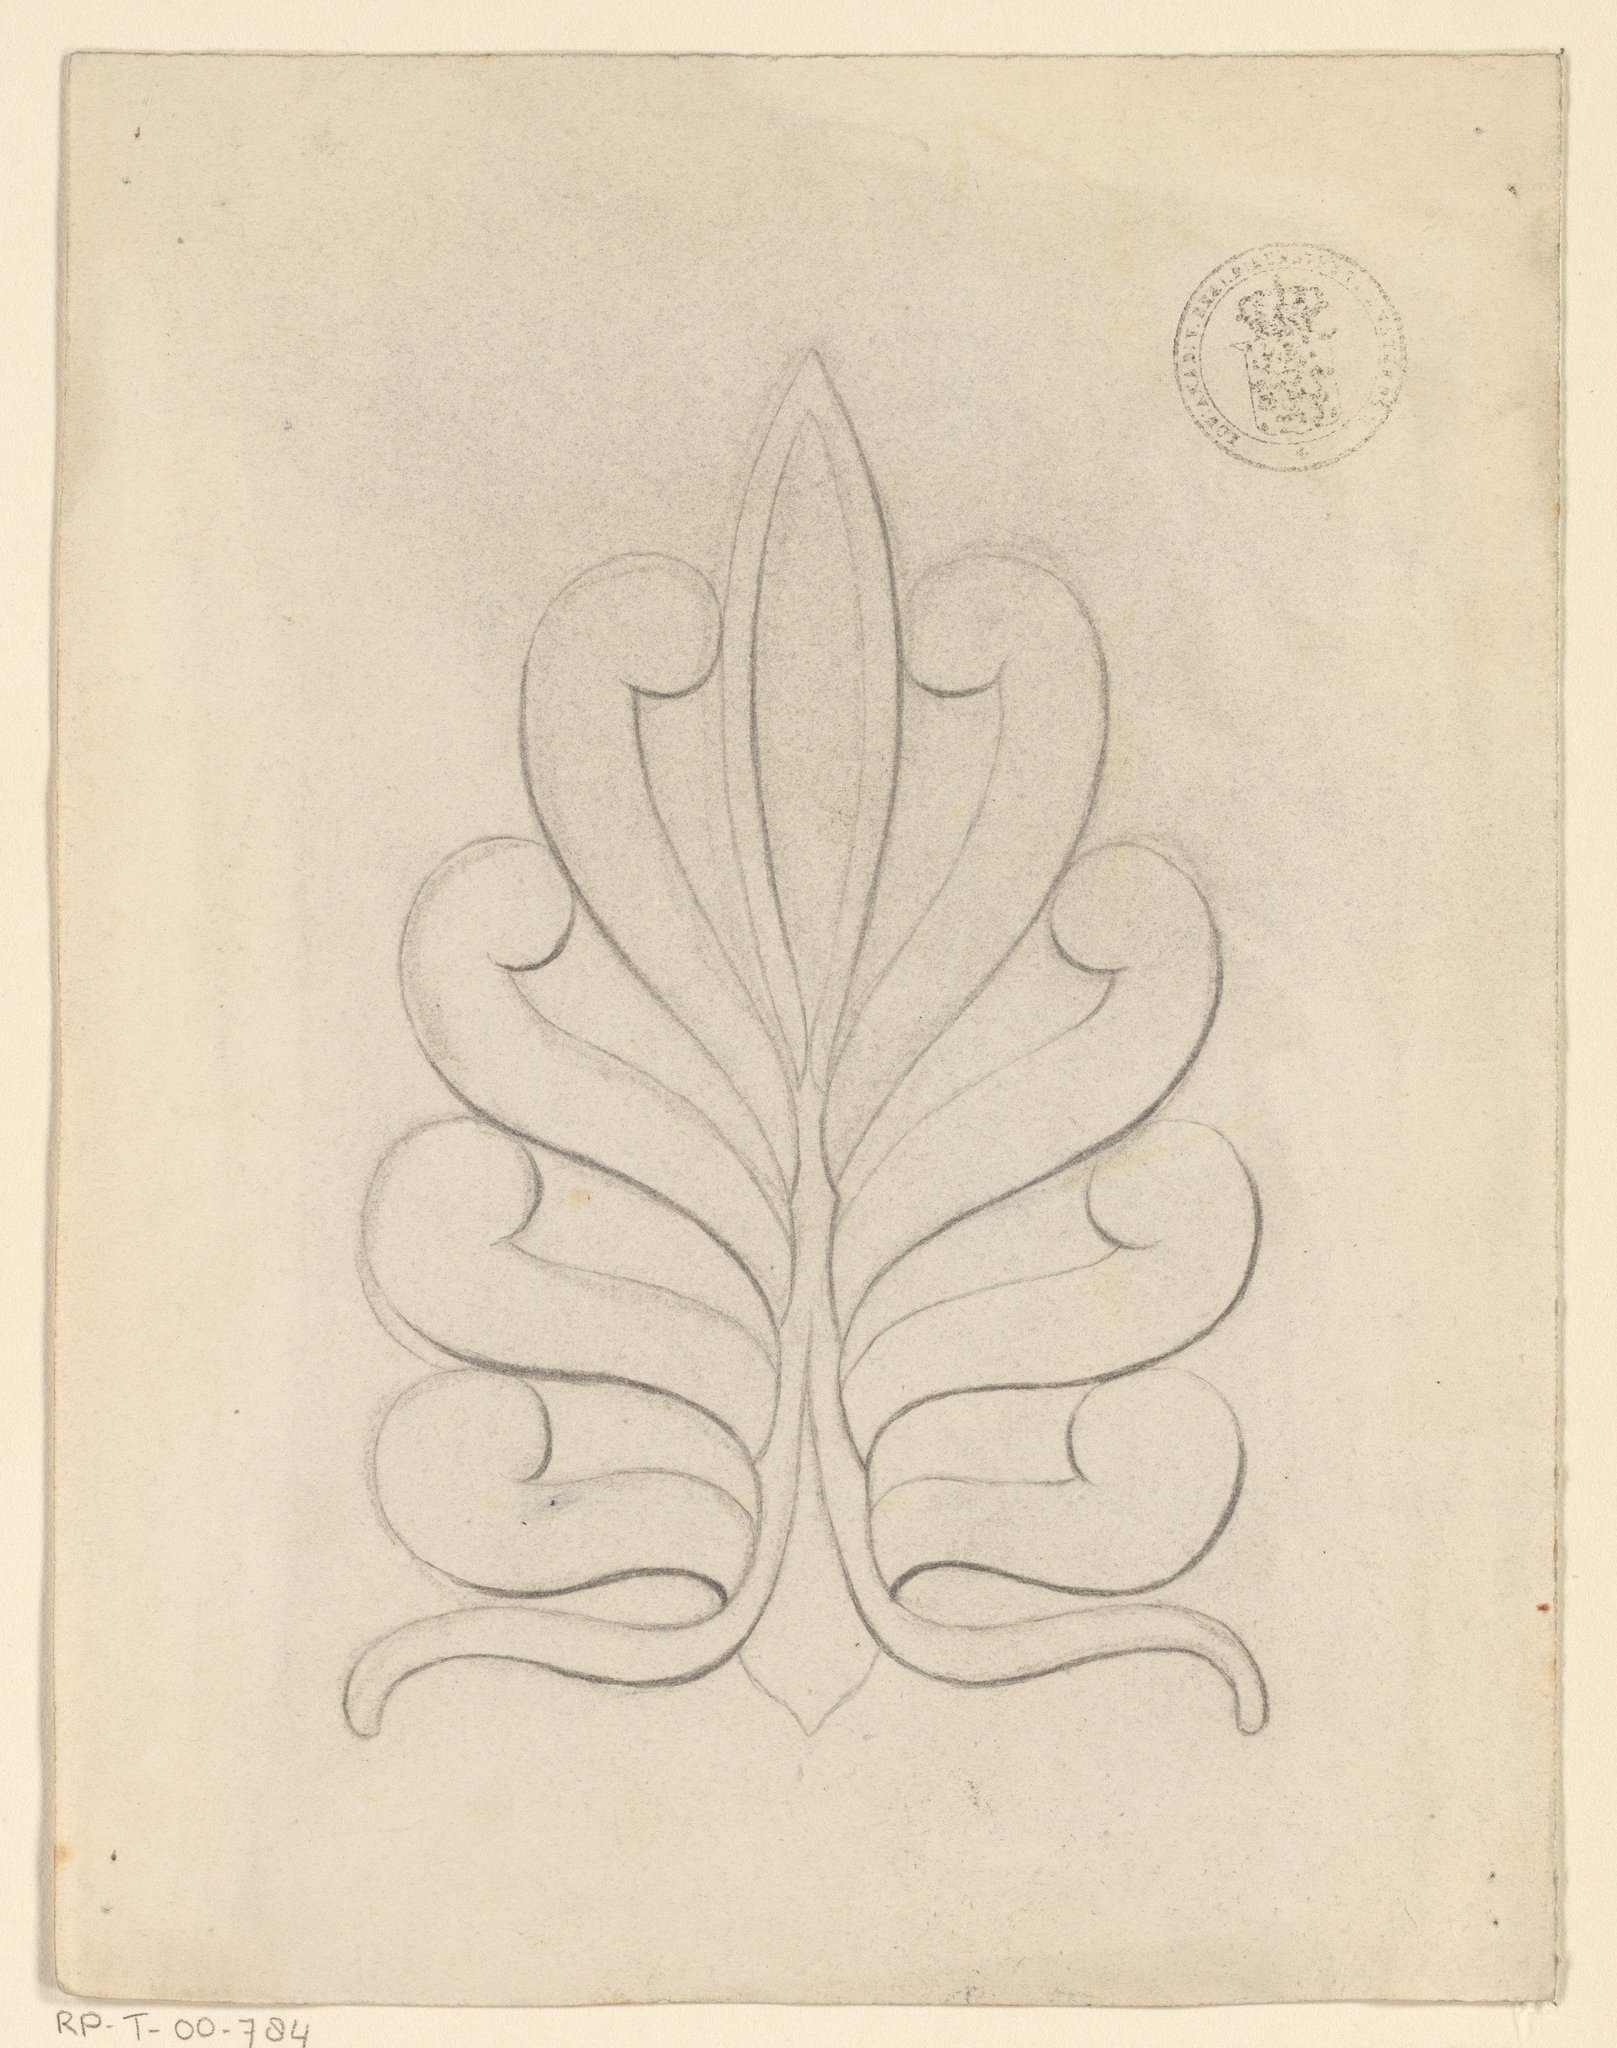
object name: ornamenttekening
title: Floraal ornament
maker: Anonymous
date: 1700-1900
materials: chalk, paper, pencil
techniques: pouncing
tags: flowers ~ ornament - aa - stylized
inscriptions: stamp: Lugt 10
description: Ontwerp voor een gestileerd floraal ornament.